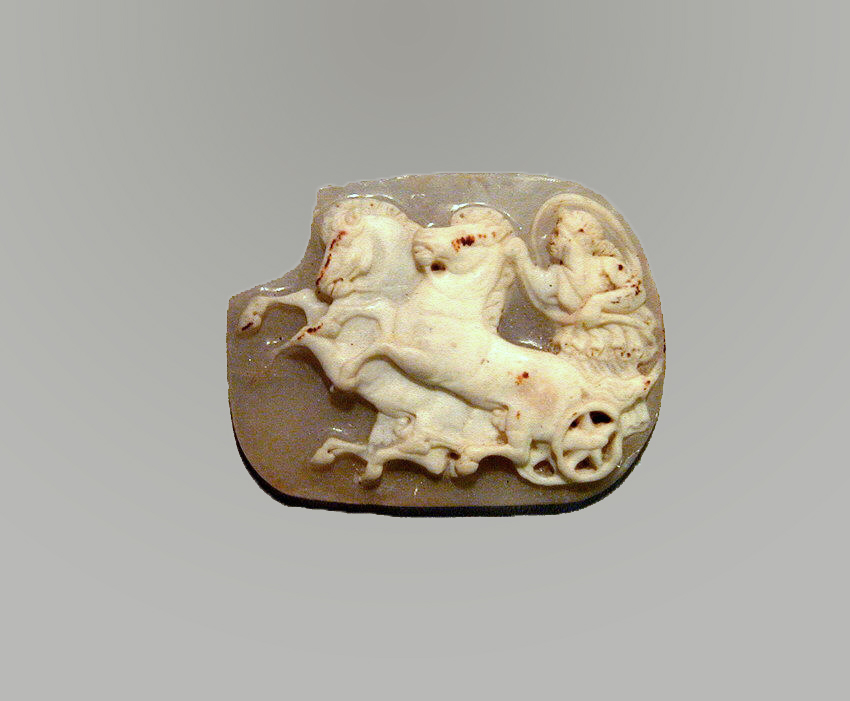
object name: cameo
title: Sardonyx cameo of Aurora driving her chariot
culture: greek or roman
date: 100 BCE-100 CE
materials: gemstone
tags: women,horses,chariots